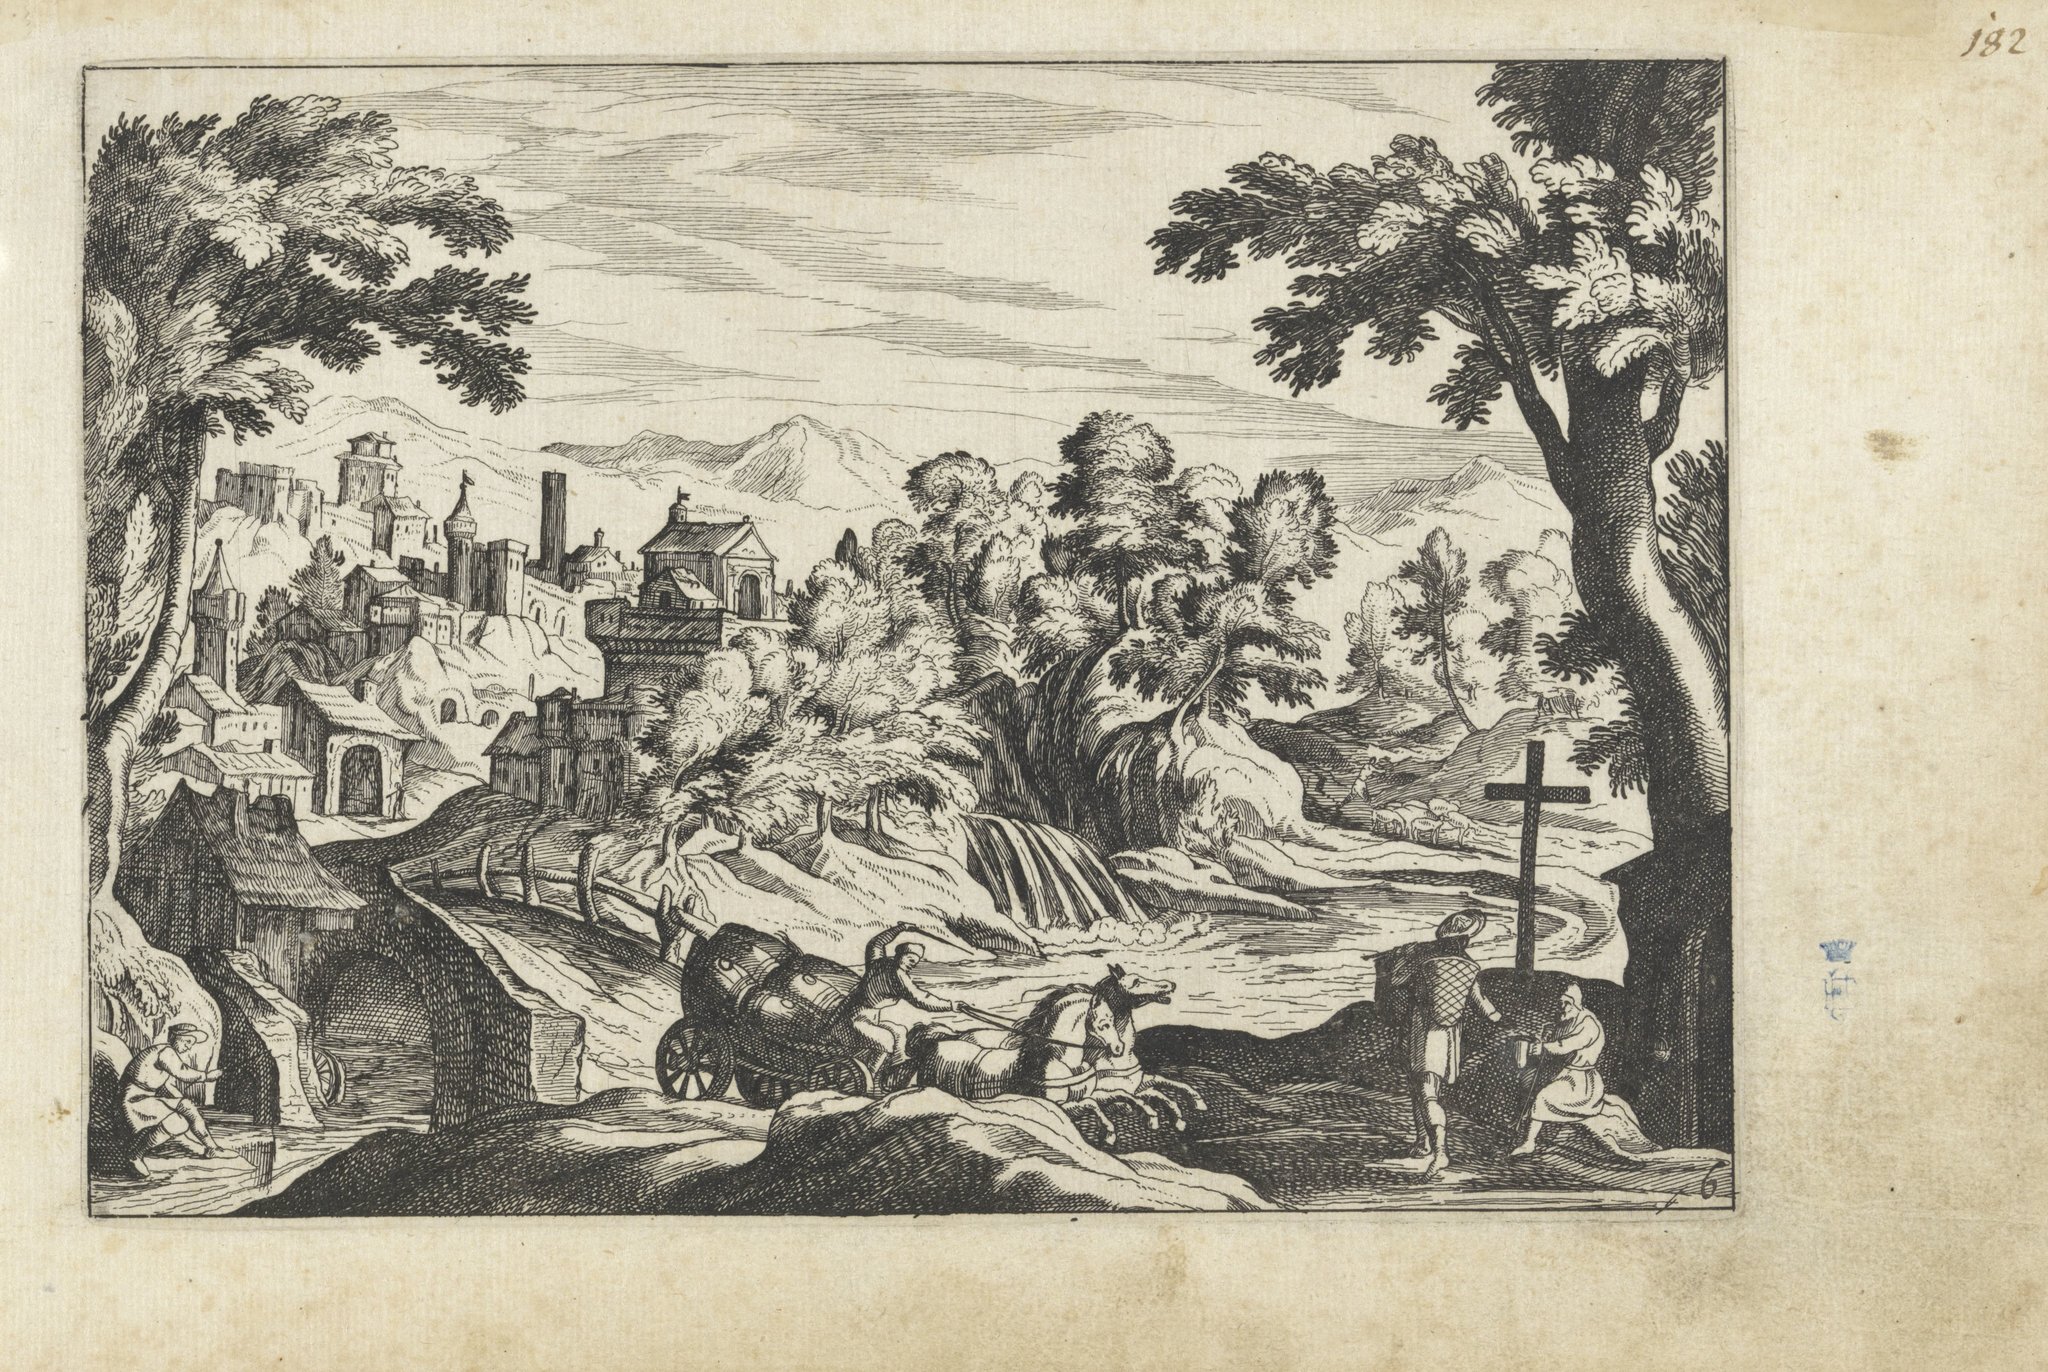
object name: print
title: Landschap met paard en wagen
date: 1612-1652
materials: paper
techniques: engraving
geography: amsterdam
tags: giving alms or other charity, e.g.: handing out food, village, bridge, four-wheeled vehicle drawn by two animals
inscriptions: collector's mark: Lugt 2760, collector's mark: Lugt 2228, number: ‘6’ Lugt, collector's mark: 845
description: Heuvelachtig landschap met gebouwen. Op de voorgrond een brug en paard en wagen. Rechtsvoor zit een monnik te bedelen bij een crucifix. Spiegelbeeldige kopie naar Tempesta (bar. 1175)